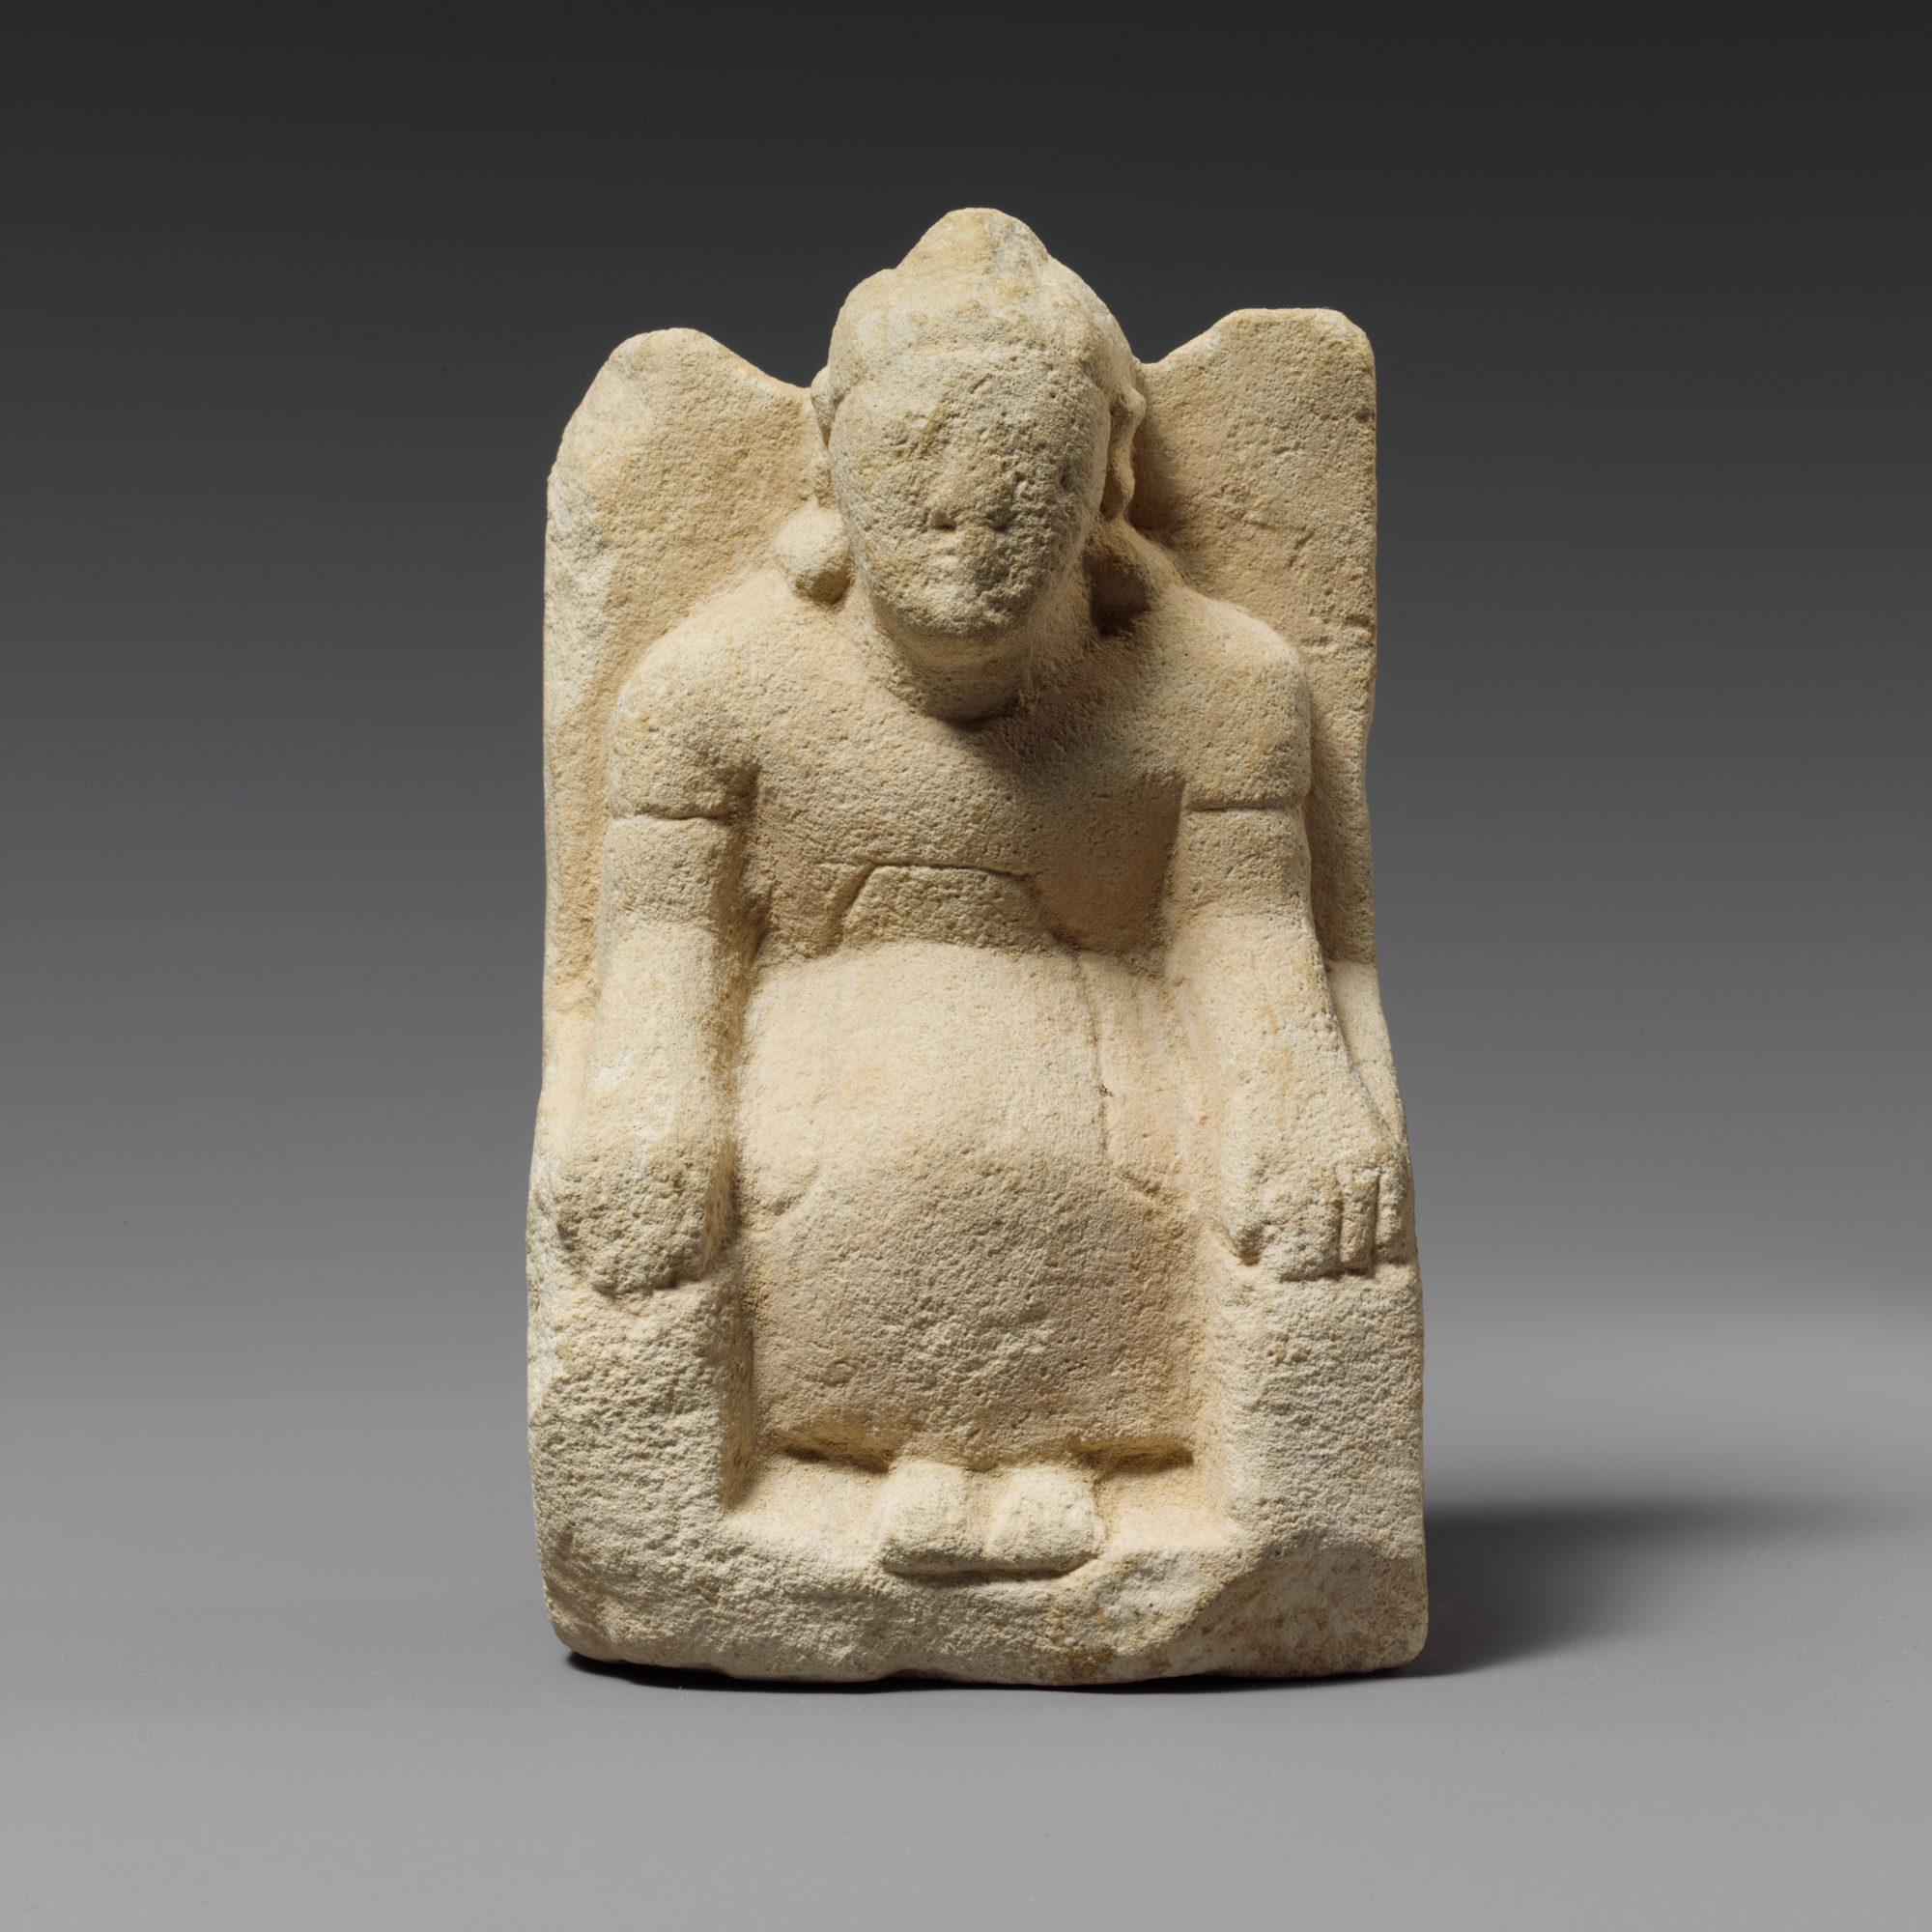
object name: statuette of a deity or votary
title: Limestone statuette of a seated beardless male votary with a helmet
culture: cypriot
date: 600-551 BCE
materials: limestone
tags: men